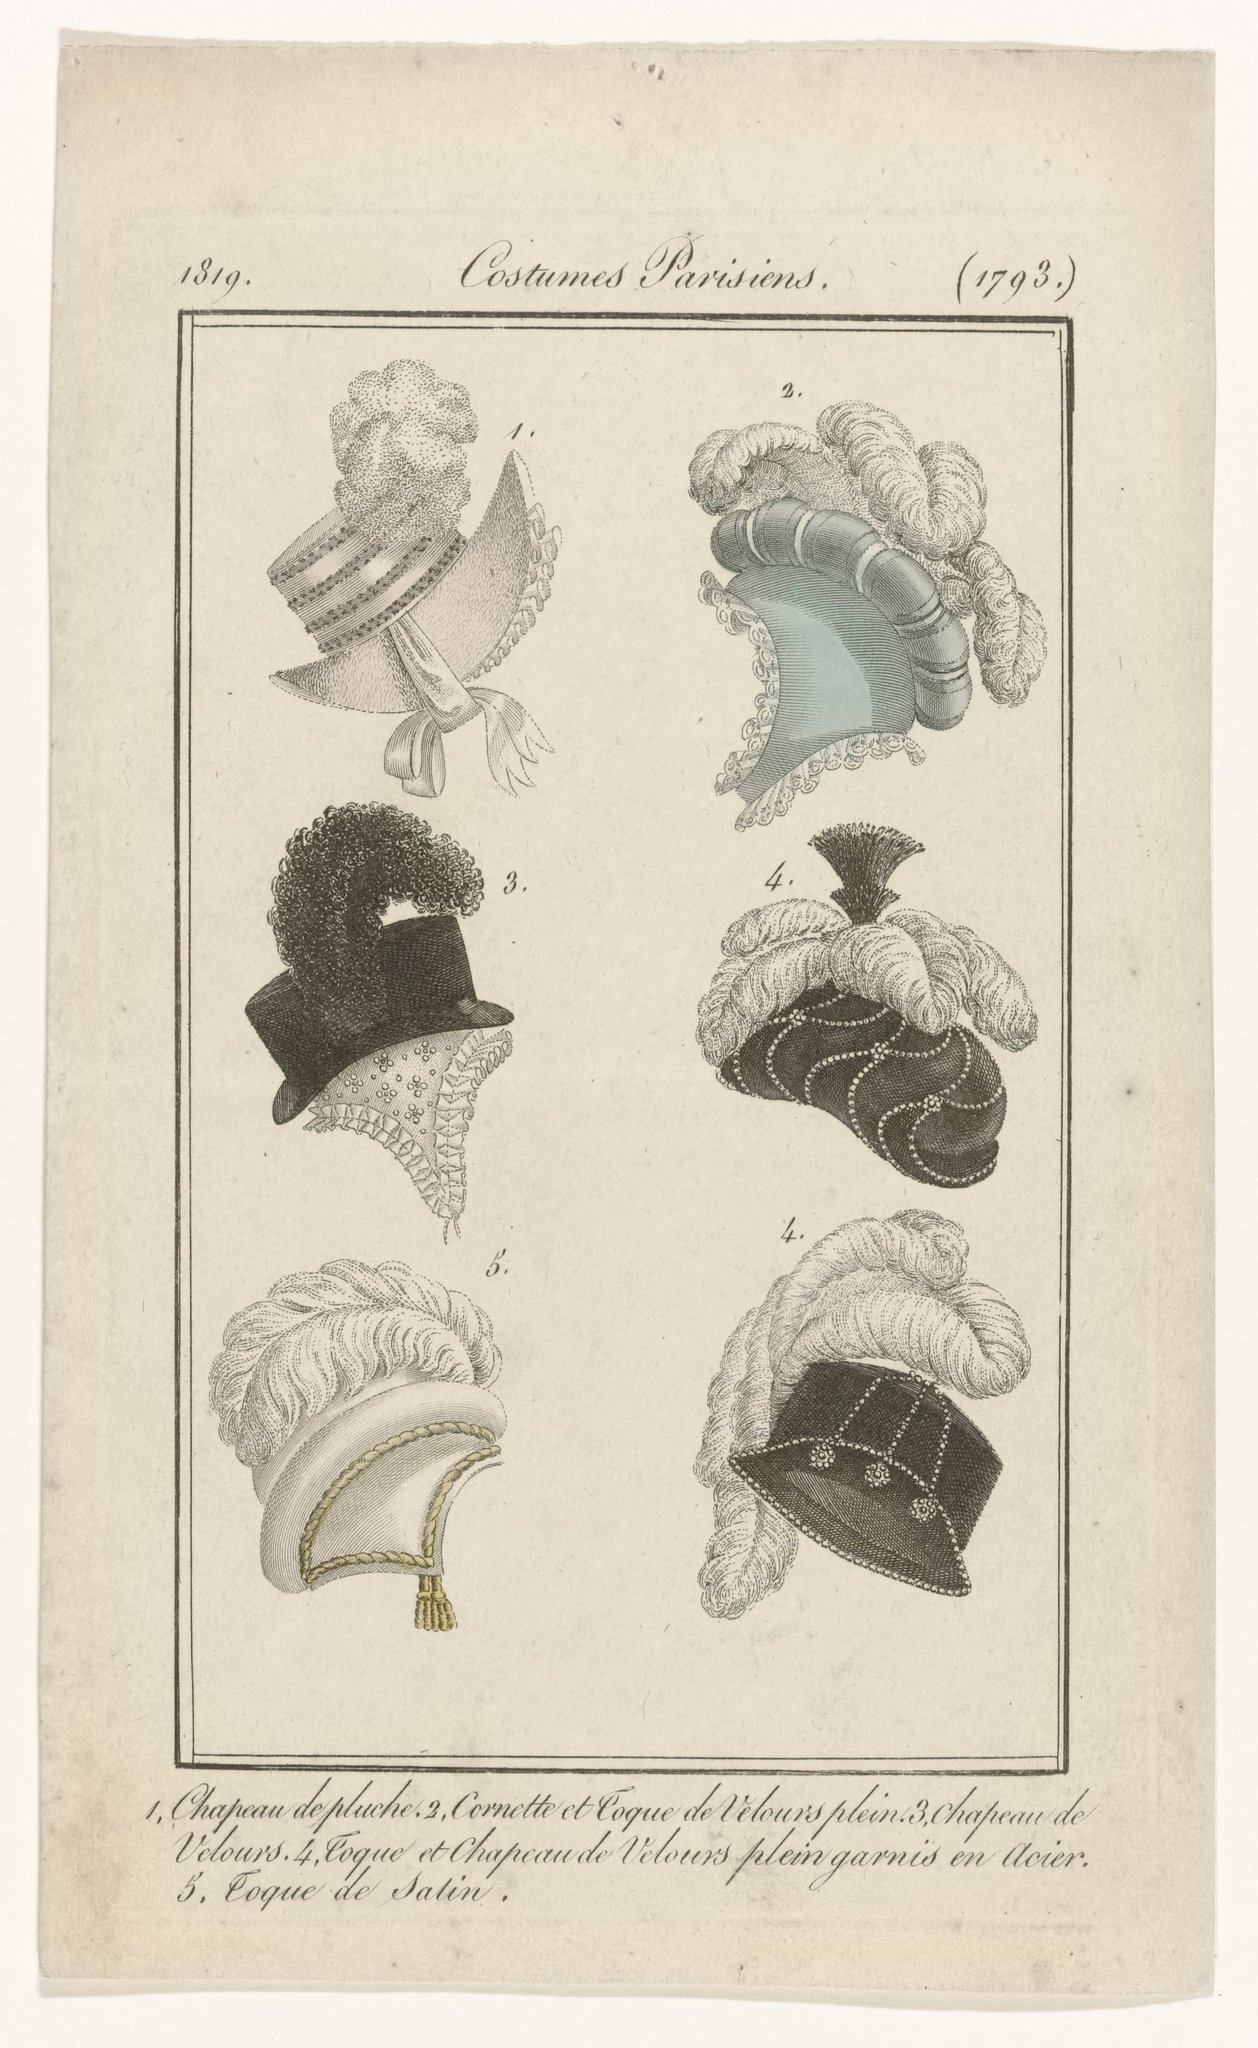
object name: fashion print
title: Journal des Dames et des Modes, Costumes Parisiens, 10 février 1819, (1793): 1. Chapeau de pluch (...)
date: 1819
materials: paper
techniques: engraving, hand coloring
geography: paris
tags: head-gear: toque (+ women's clothes), head-gear (cornette) (+ women's clothes), fashion plates, head-gear: hat (+ women's clothes)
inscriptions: caption: ‘1. Chapeau de pluche. 2, Cornette et Toque de Velours plein. 3, Chapeau de Velours. 4,Toque et Chapeau de Velours plein garnis en Acier. 5, Toque de Satin’, title: ‘Costumes Parisiens.’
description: Zes verschillende hoeden in een kader, genummerd één tot en met vijf. 1. Hoed van pluche. 2. ´Cornette´ en toque van effen fluweel. 3. Hoed van fluweel. 4. Toque en hoed van effen fluweel gegarneerd met metaal. 5. Toque van satijn. De prent maakt deel uit van het modetijdschrift Journal des Dames et des Modes, uitgegeven door Pierre de la Mésangère, Parijs, 1797-1839.